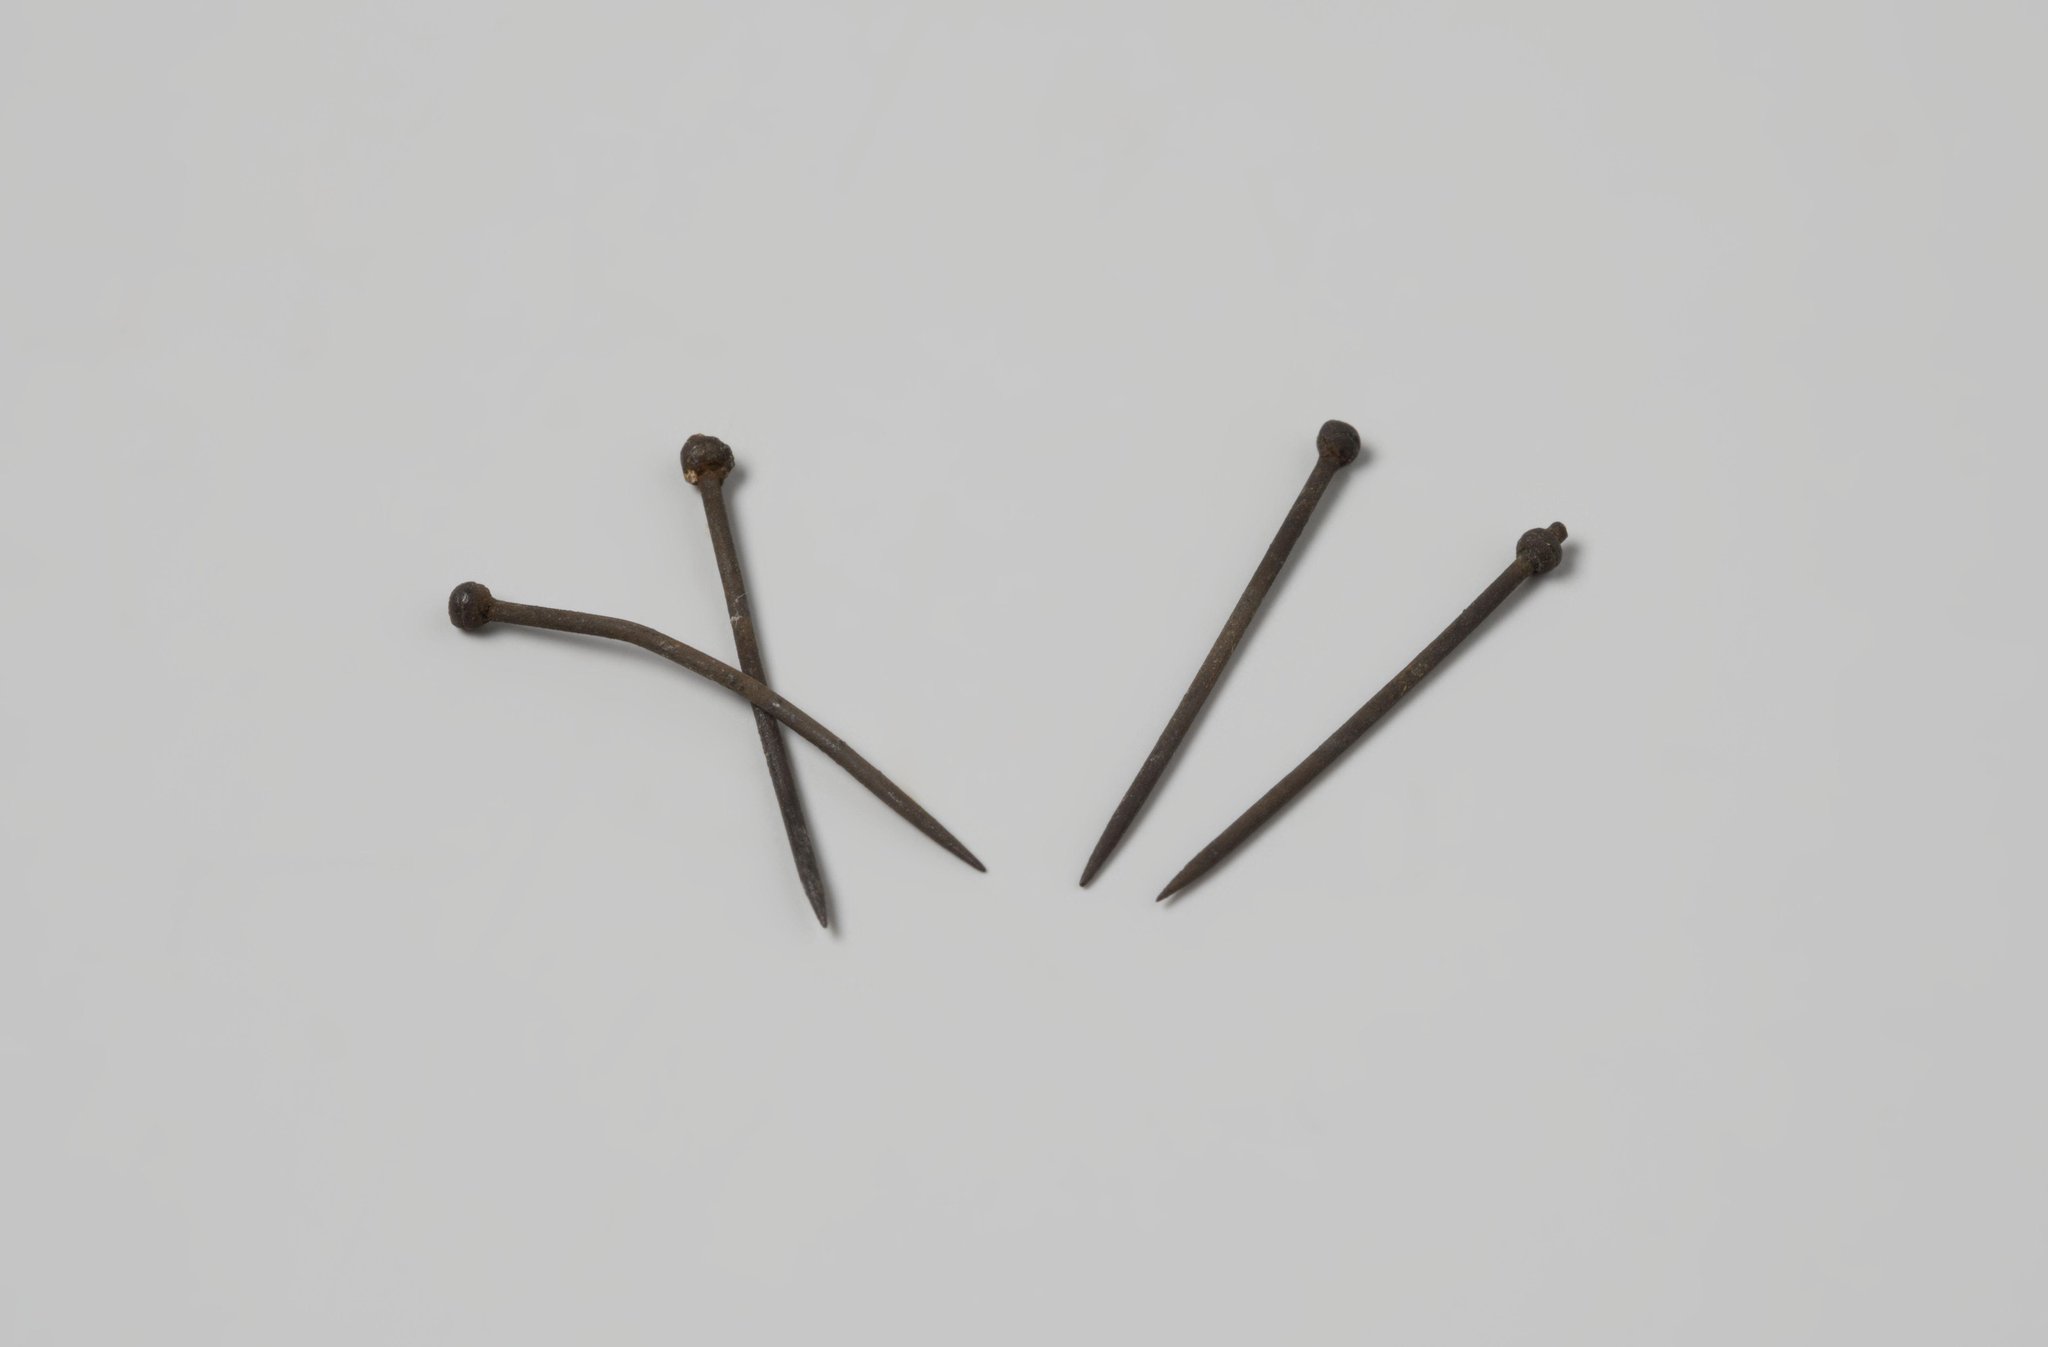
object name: pin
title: Spelden uit het wrak van de Oost-Indiëvaarder Hollandia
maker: Anonymous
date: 1700-1743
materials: copper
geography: netherlands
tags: verenigde oostindische compagnie, hollandia (schip), annet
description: Pin, tools and instruments, sewing and sailmaking, pin; id. NG 1979-434H.